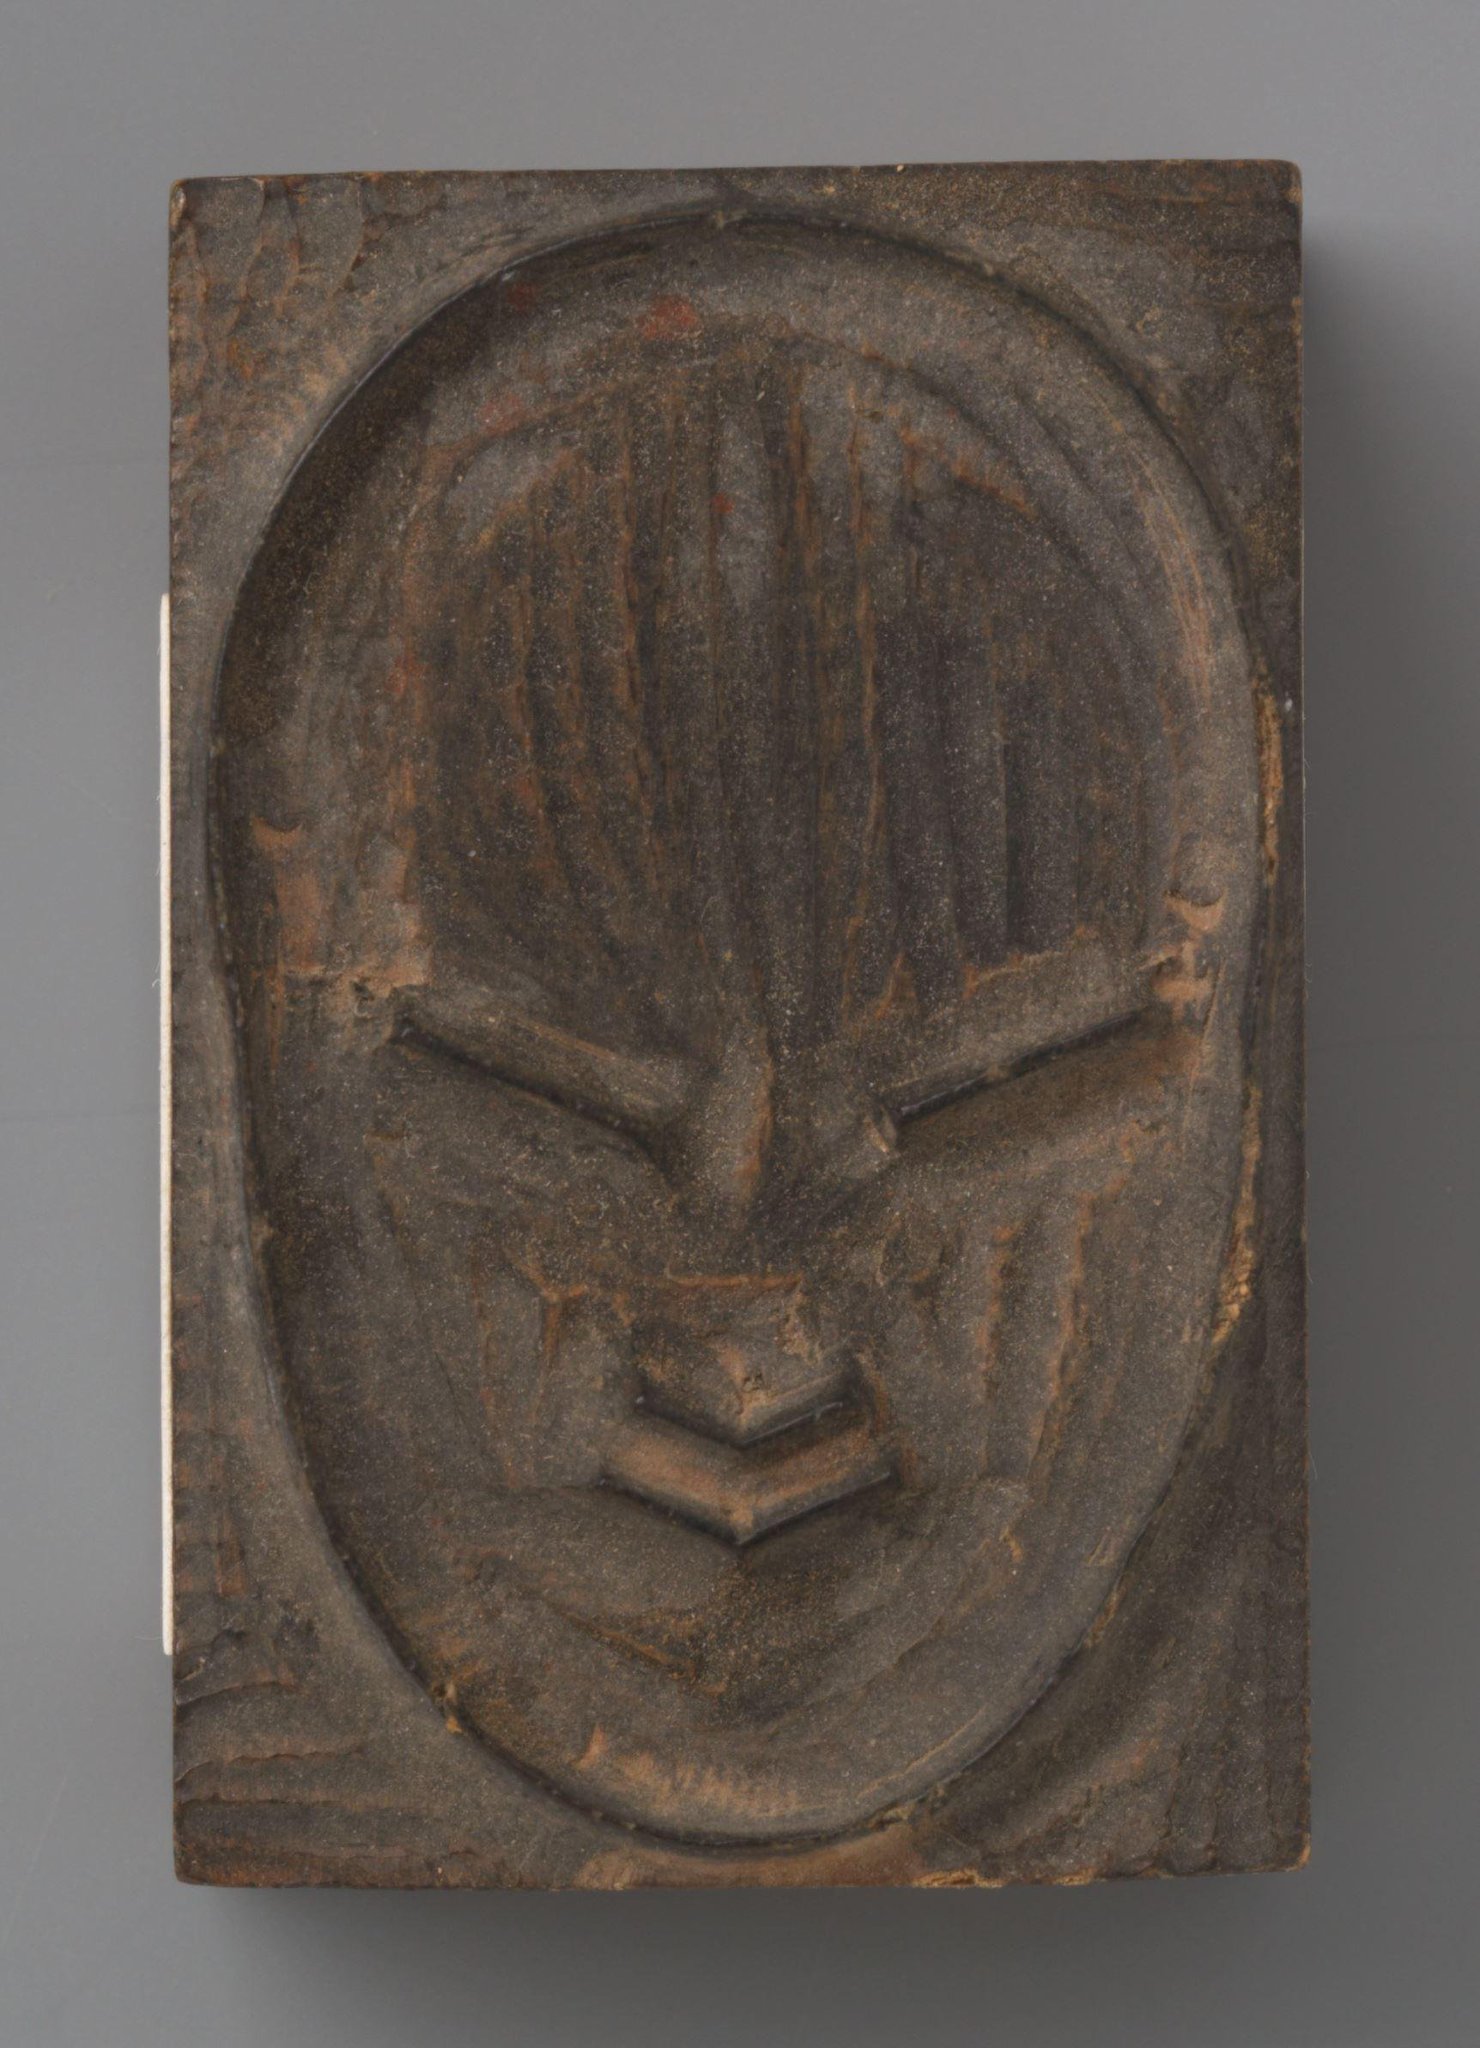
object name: wood block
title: Gestileerde gezichten of maskers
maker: alexander cranendoncq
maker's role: draughtsman, print maker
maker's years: 1799-1869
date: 1809-1869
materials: wood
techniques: woodcut